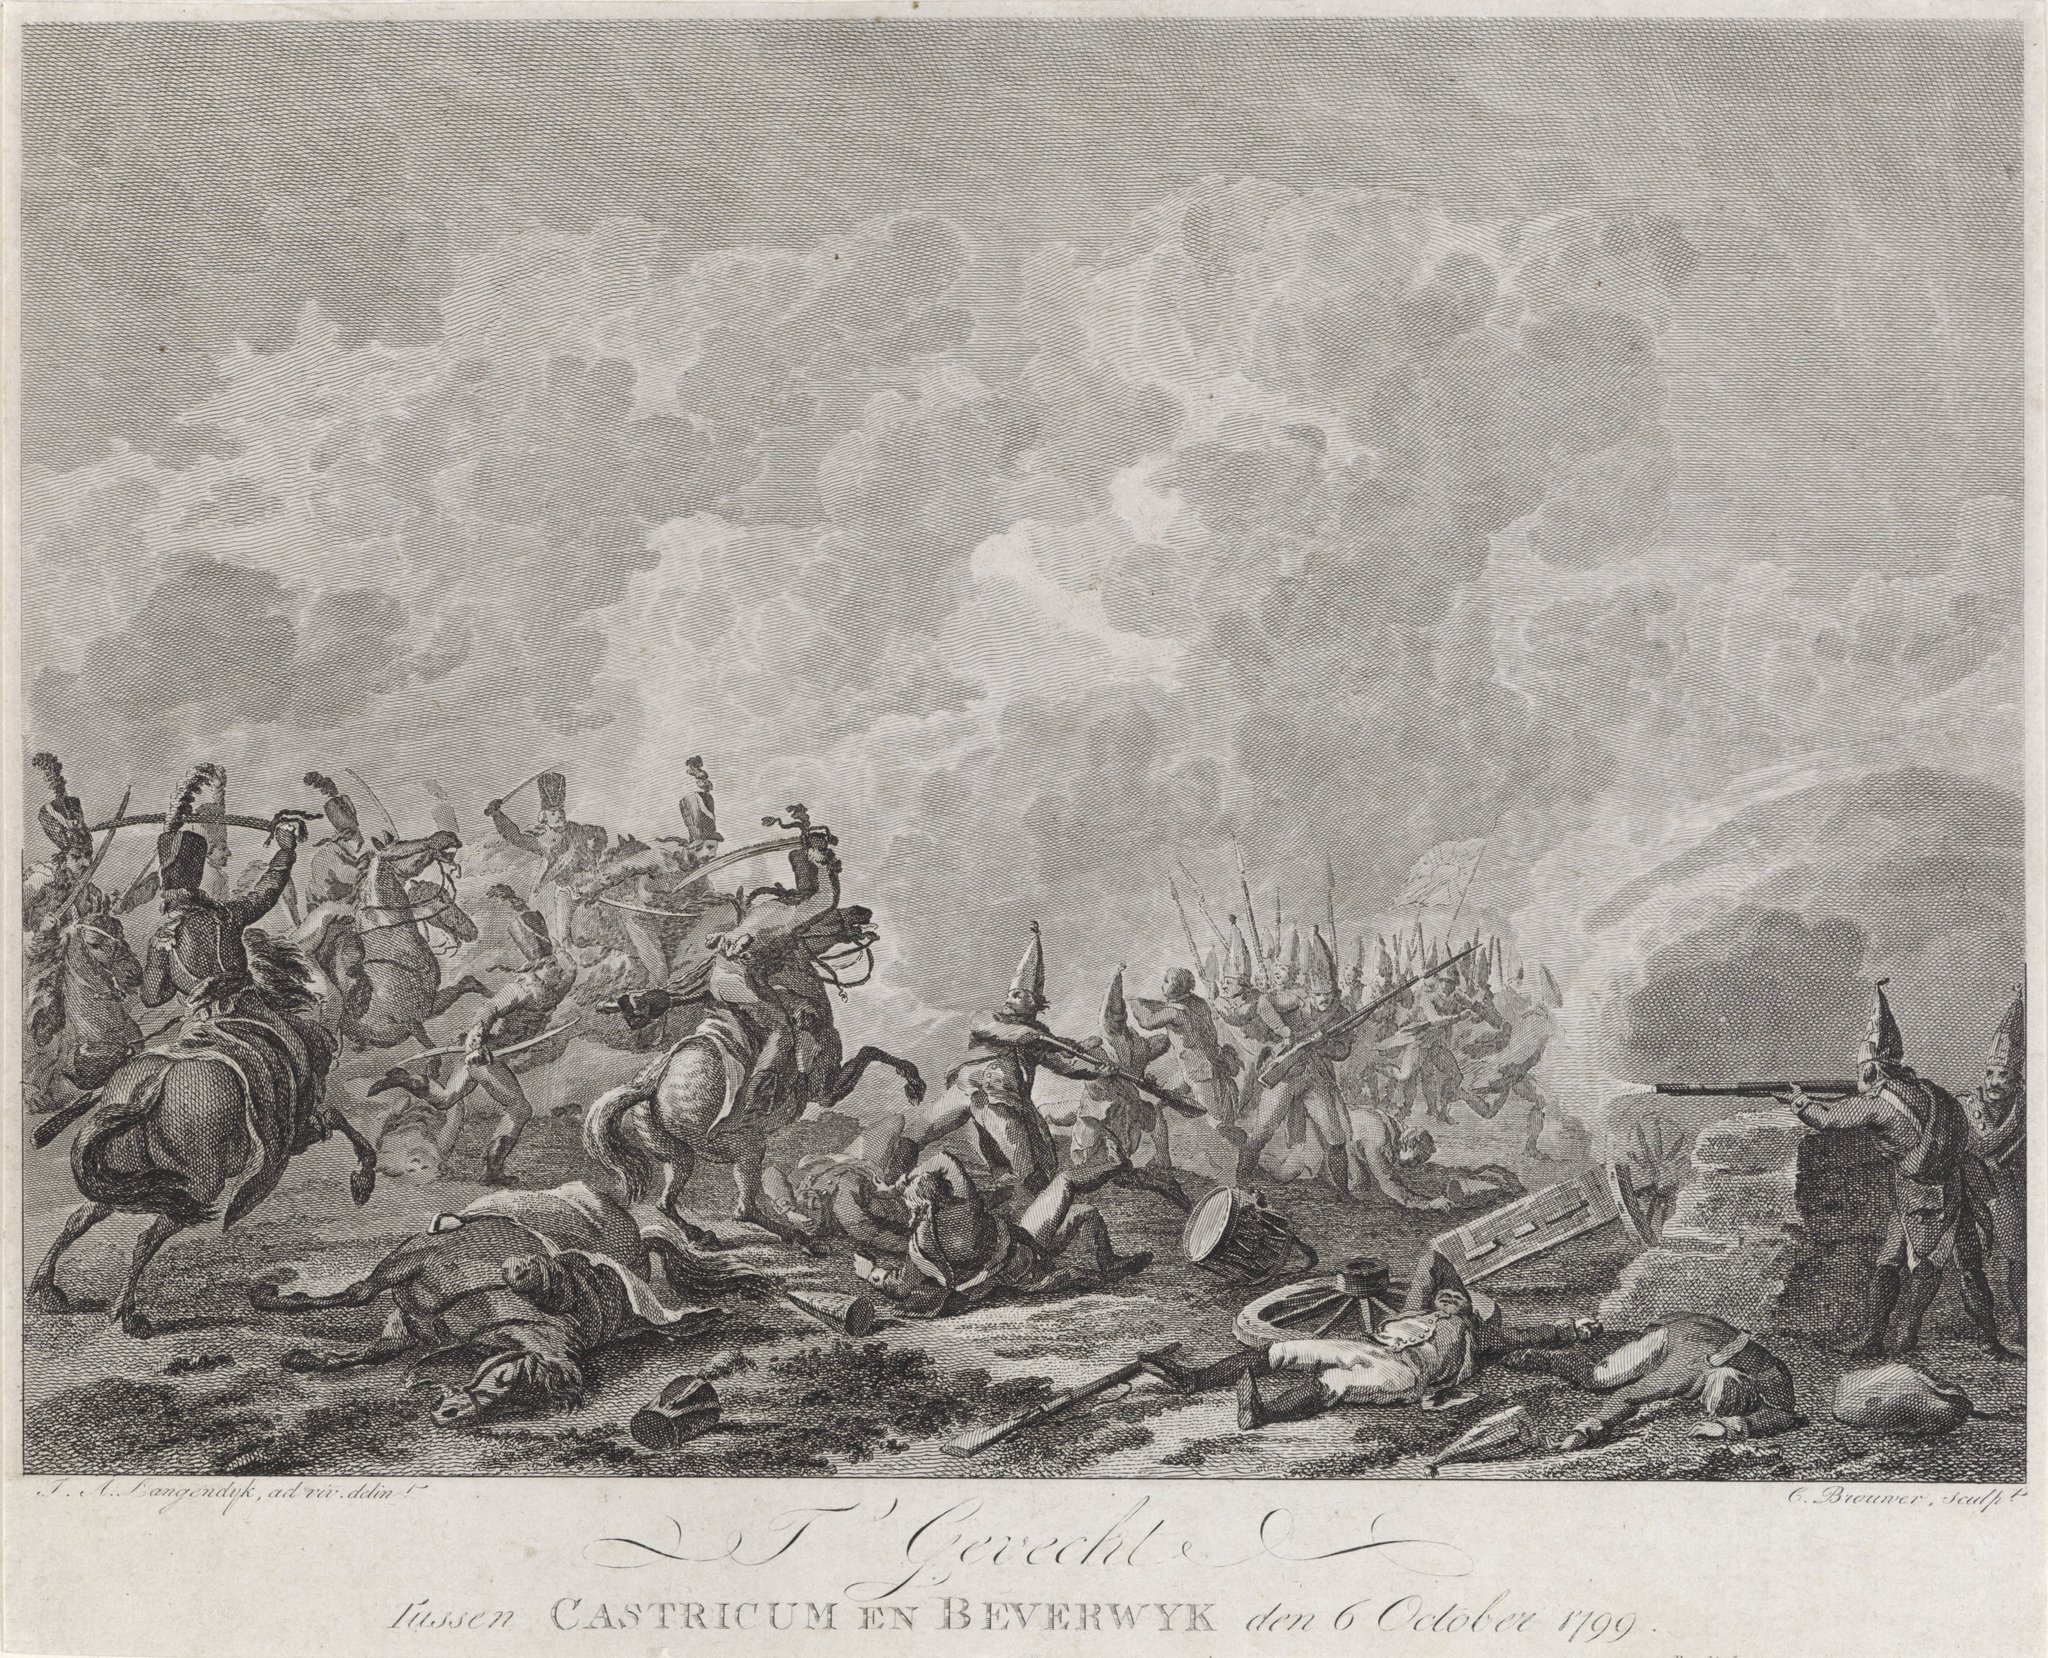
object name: print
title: Vier platen over de Engels-Russische inval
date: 1800-1802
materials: paper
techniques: engraving, etching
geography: castricum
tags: battle (+ land forces)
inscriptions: collector's mark: Lugt 2228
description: Gevechten tussen het Frans-Bataafse leger en de Brits-Russische invasiemacht op 6 oktober 1799, in het gebied tussen Castricum en Beverwijk.